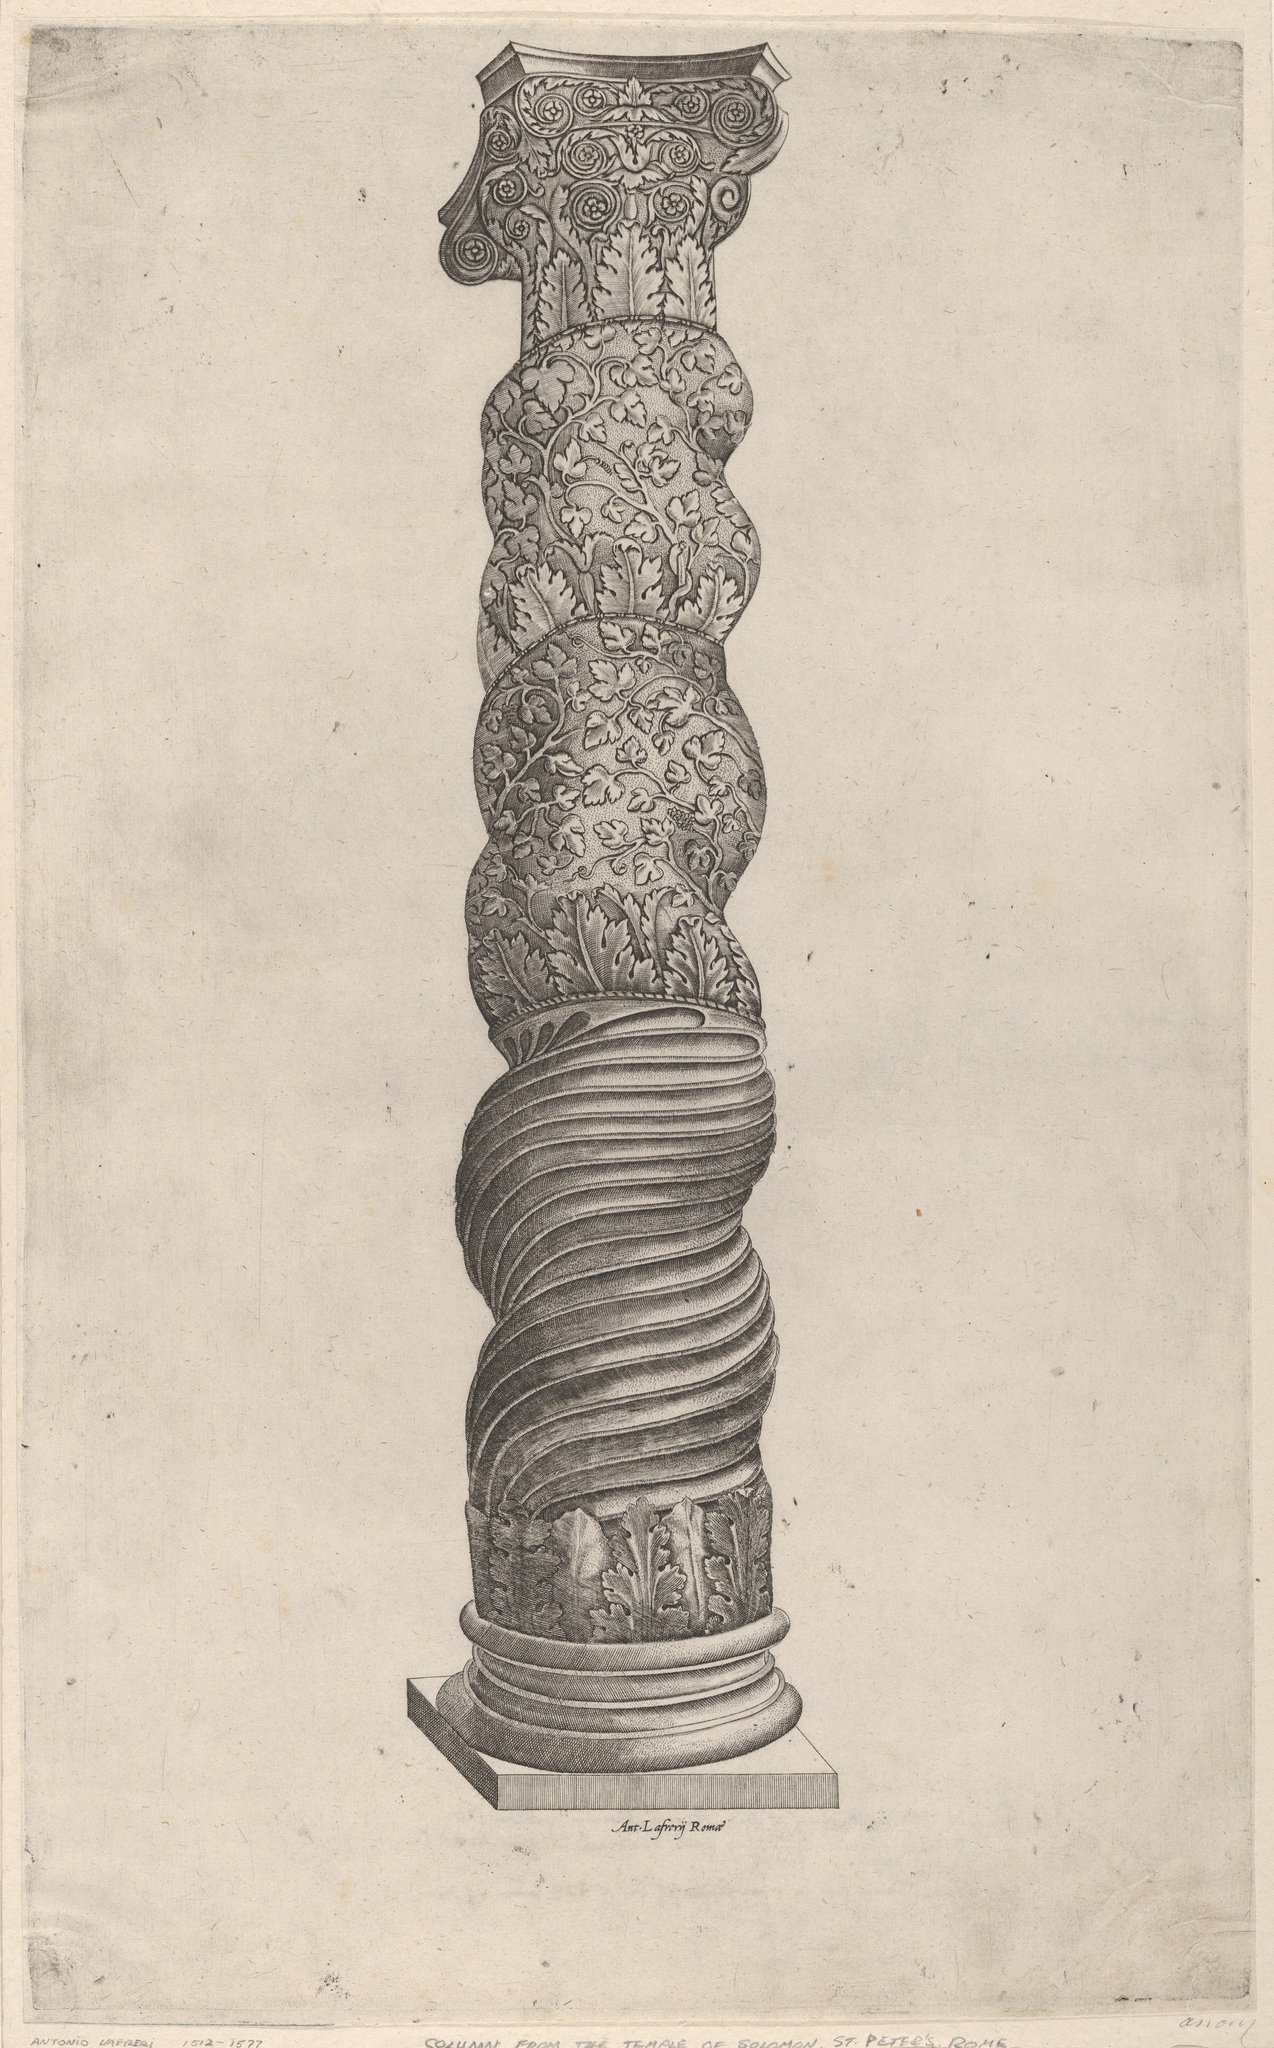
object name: print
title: Winding Column from Saint Peter's, Rome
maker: anonymous, italian, 16th century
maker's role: artist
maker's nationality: italian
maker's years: 1500-1600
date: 1540-1600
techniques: engraving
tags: columns